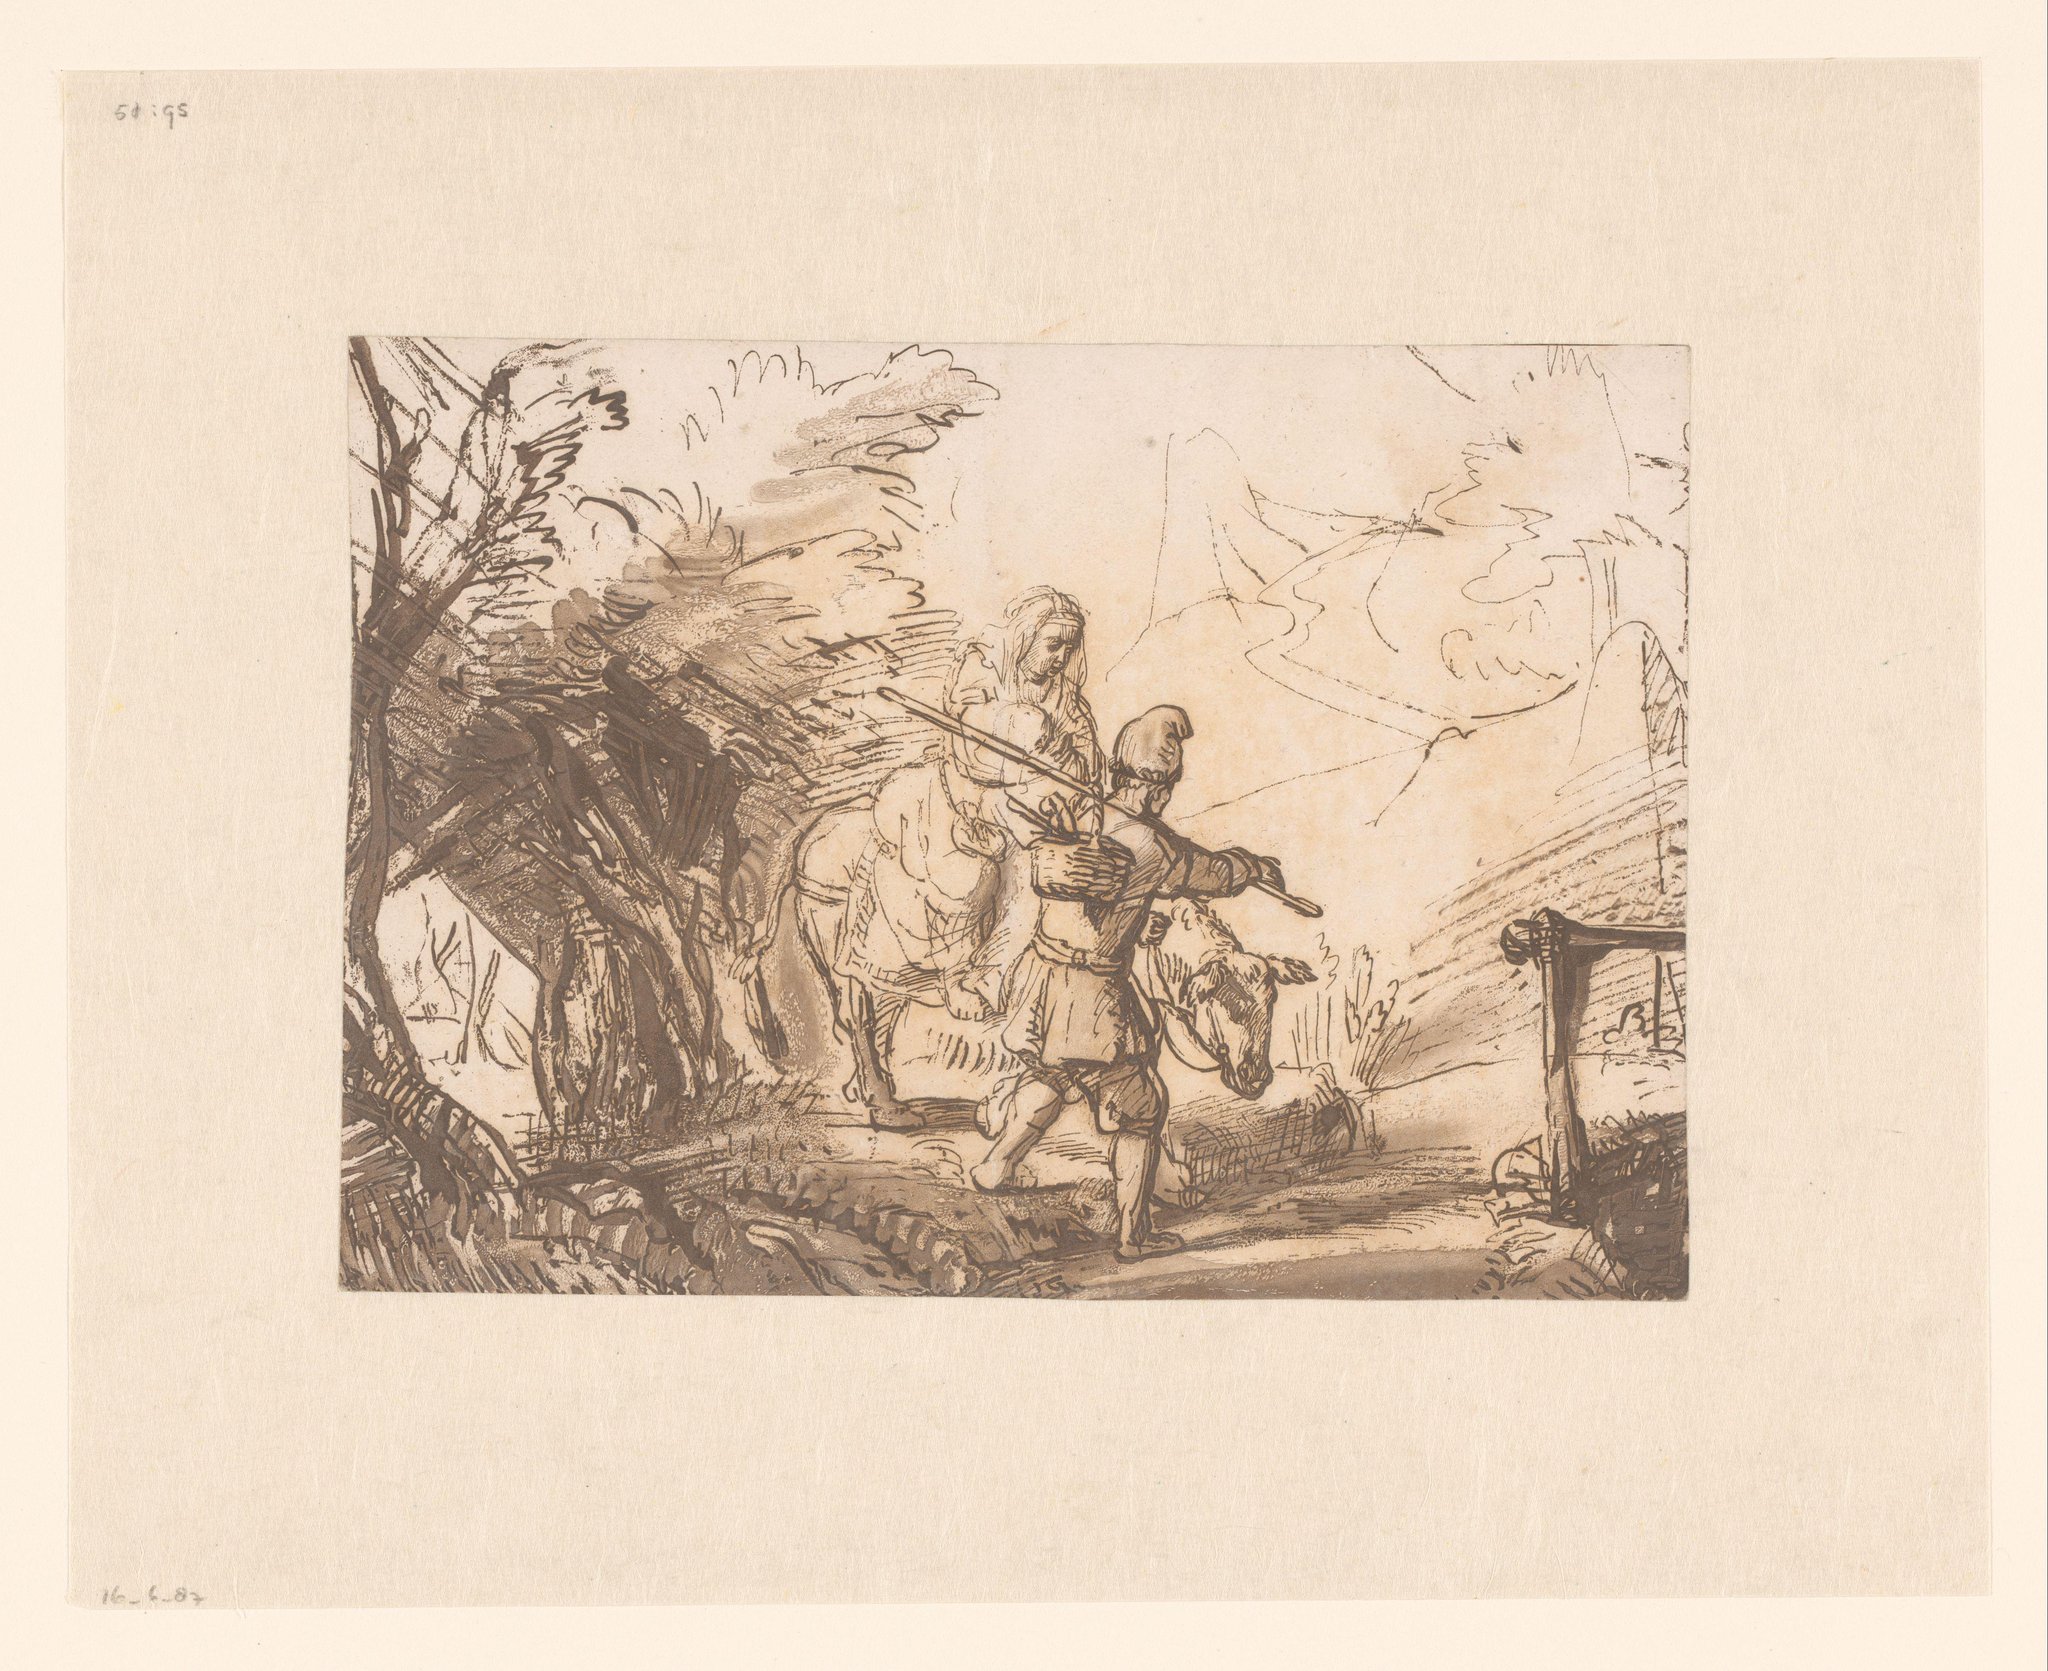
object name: print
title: Vlucht naar Egypte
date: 1780-1810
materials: paper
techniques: aquatint, etching, lithography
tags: the flight into egypt: mary, joseph, the child (and sometimes others) on their way; mary usually riding on an ass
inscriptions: collector's mark: Lugt 2228